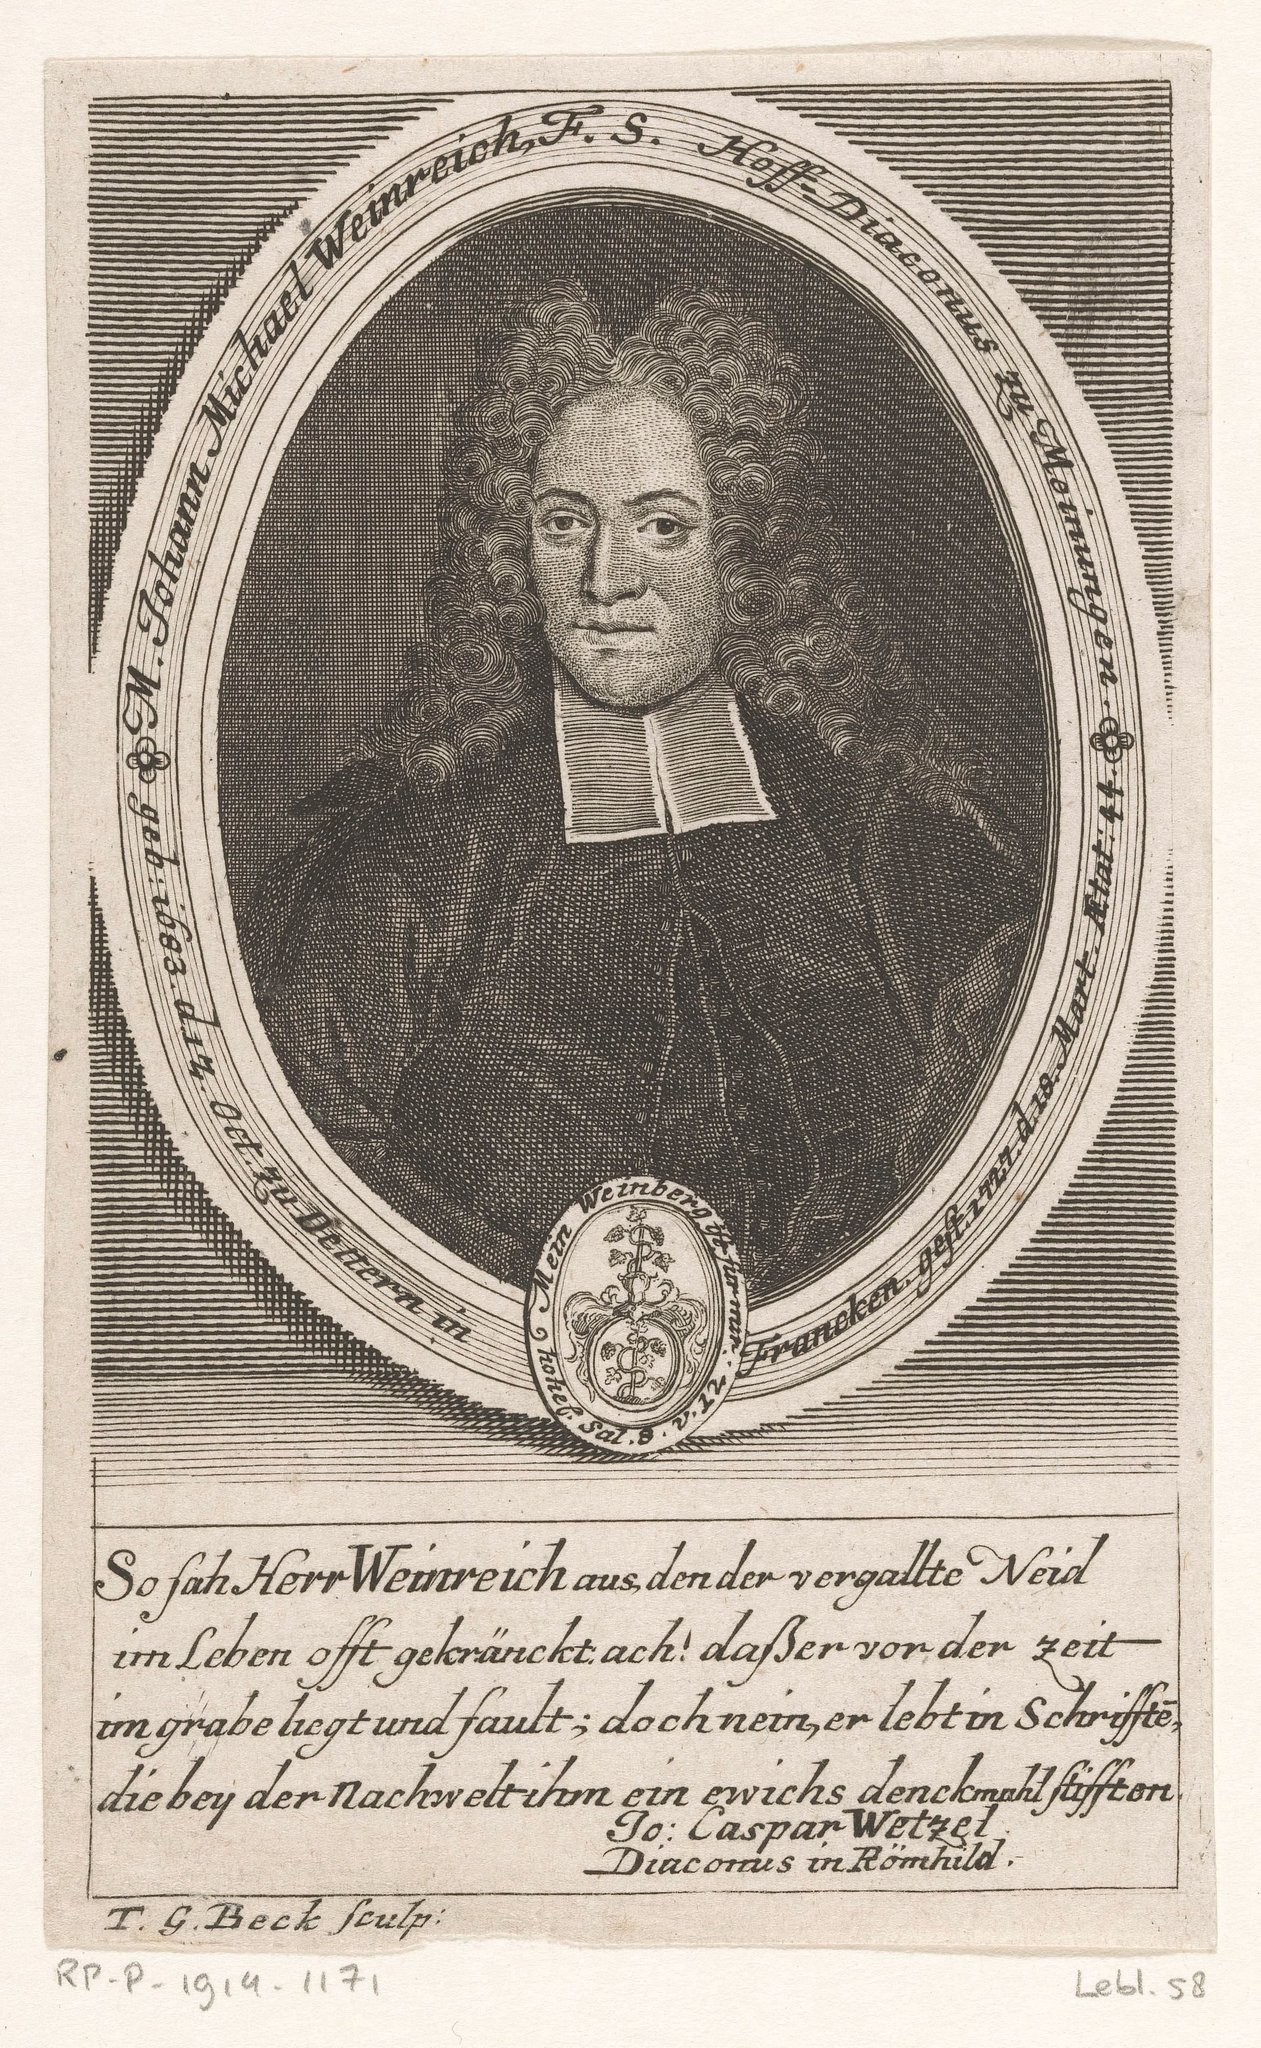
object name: print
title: Portret van Johann Michael Weinreich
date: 1727-1755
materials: paper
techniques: engraving, etching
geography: römhild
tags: historical persons, armorial bearing, heraldry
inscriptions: collector's mark: Lugt 2228